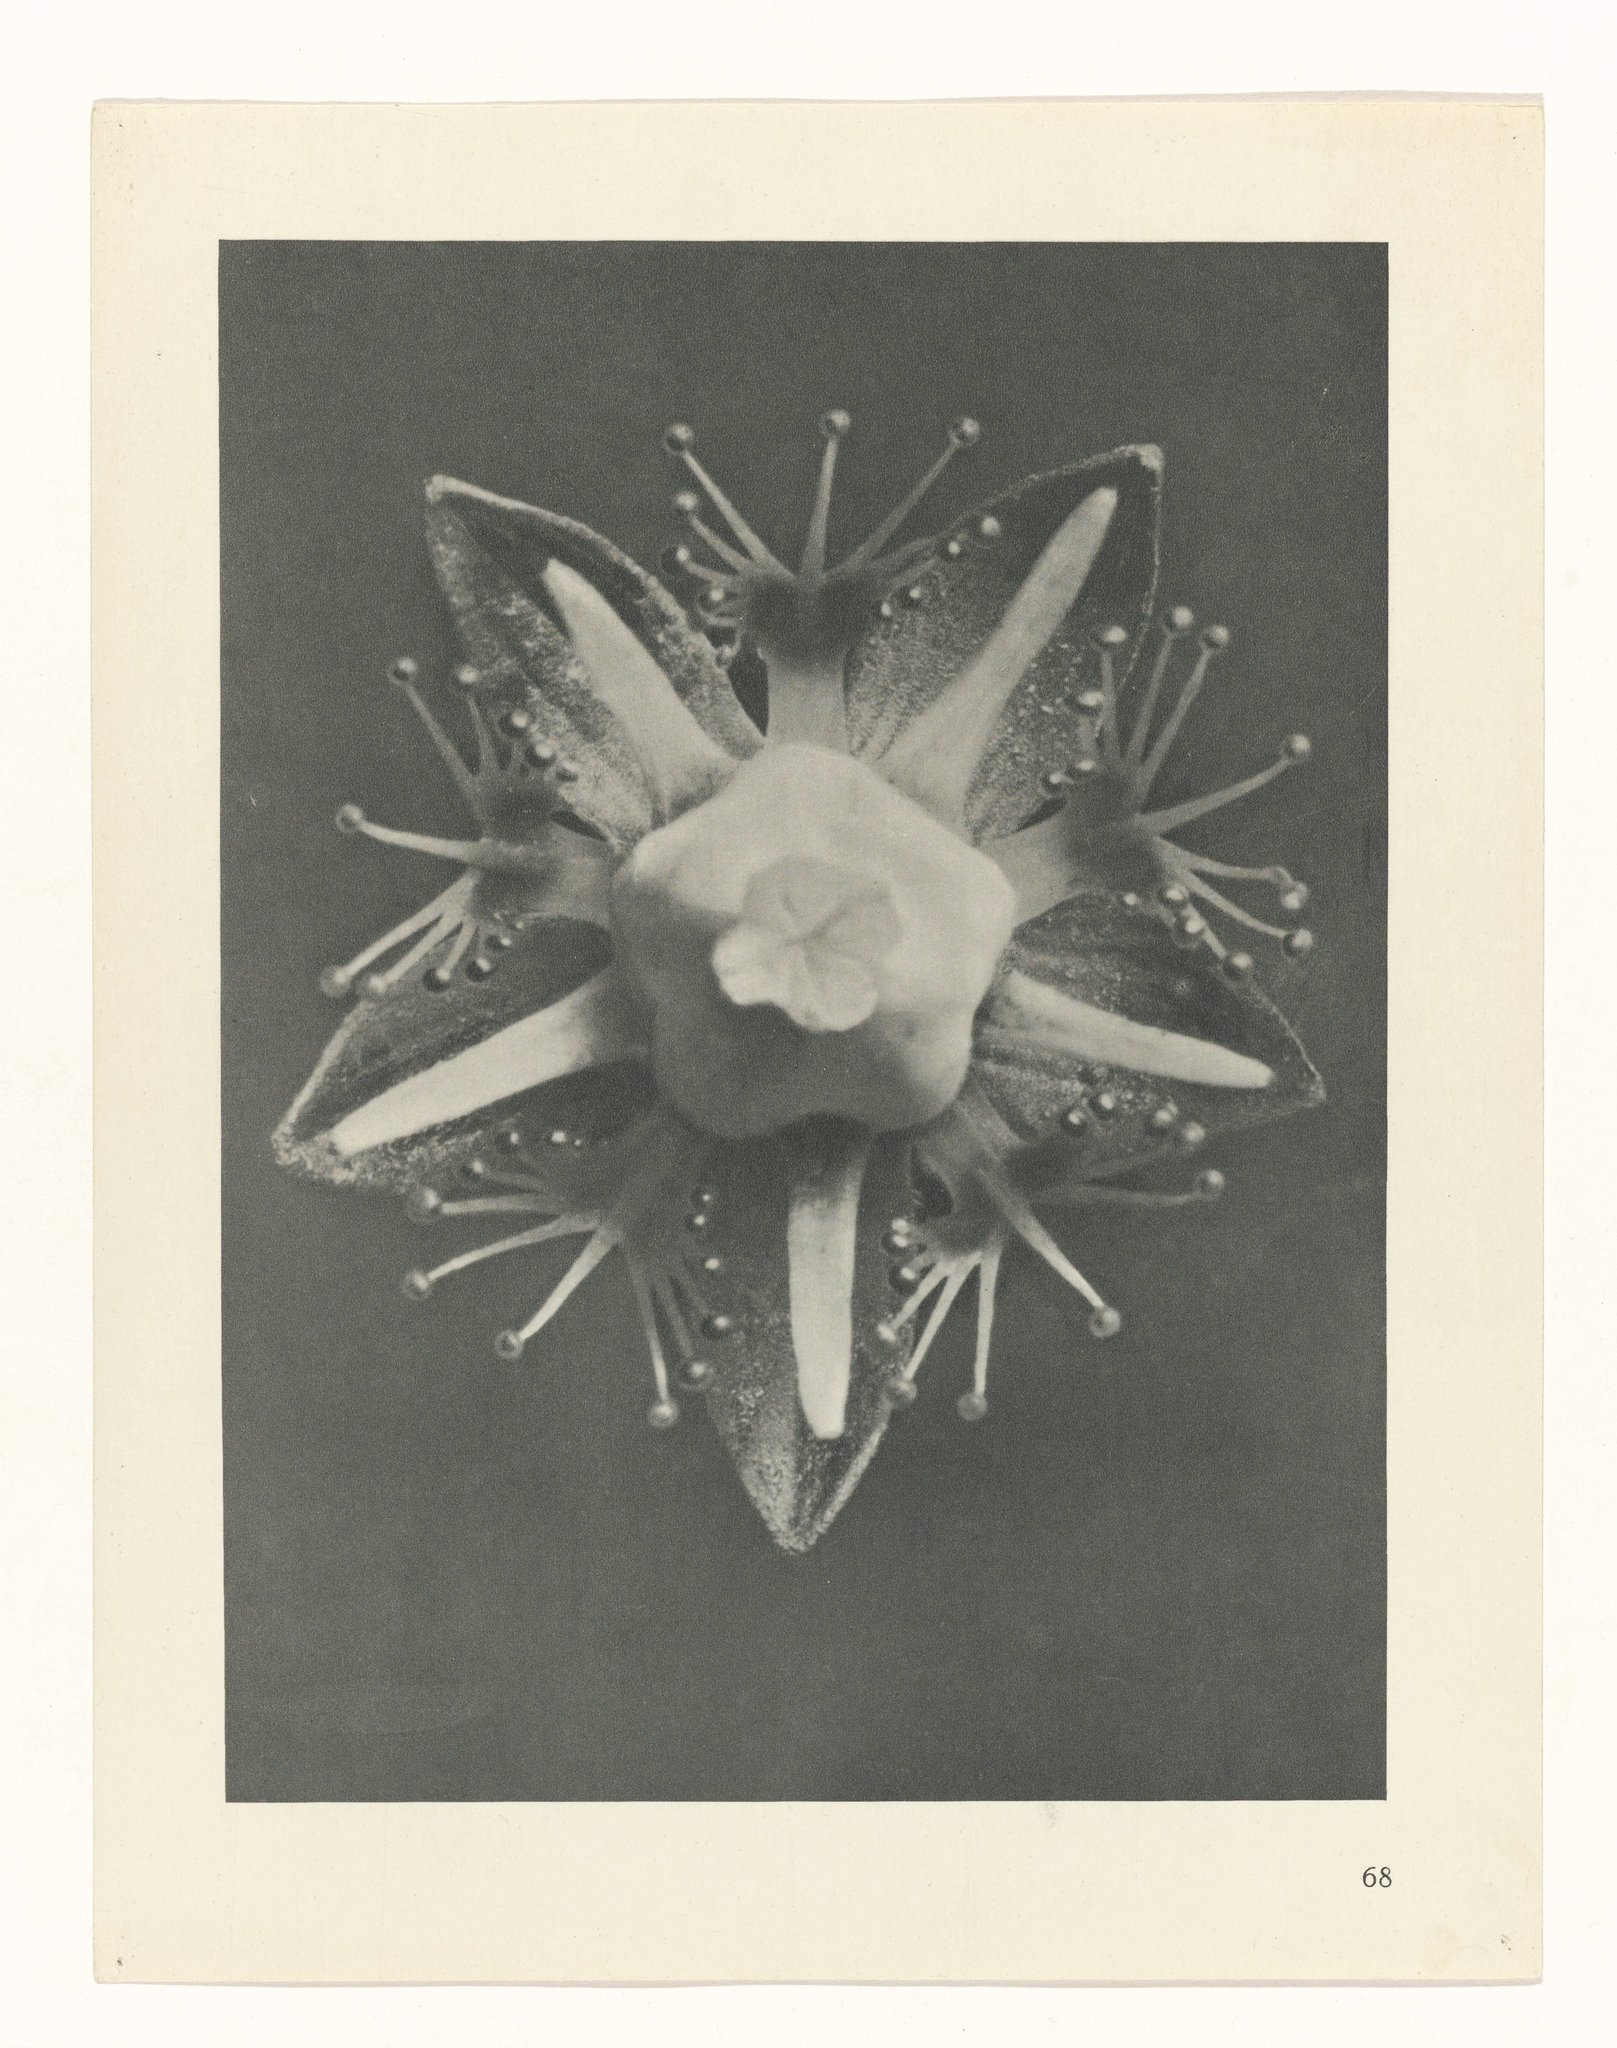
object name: photograph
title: Urformen der Kunst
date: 1928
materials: ink, paper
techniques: rotogravure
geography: berlin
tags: plants (in general)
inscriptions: number: ‘68’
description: facher Vergrößerung. Afkomstig uit losbladige uitgave.